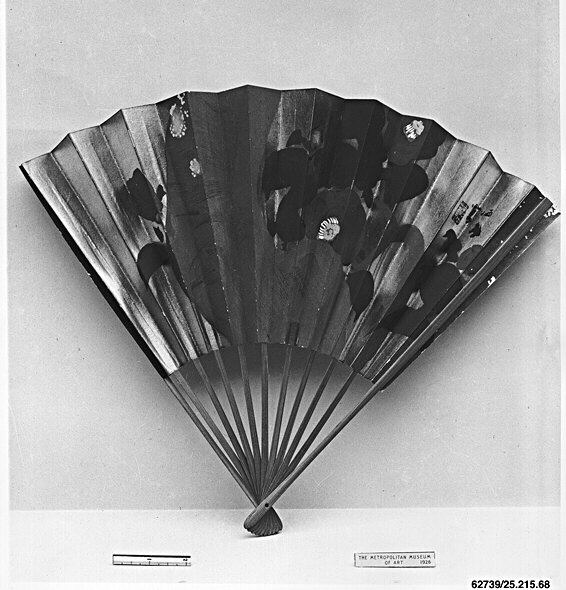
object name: folding fan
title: Fan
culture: japanese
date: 1901-2000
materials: metal, paint, paper